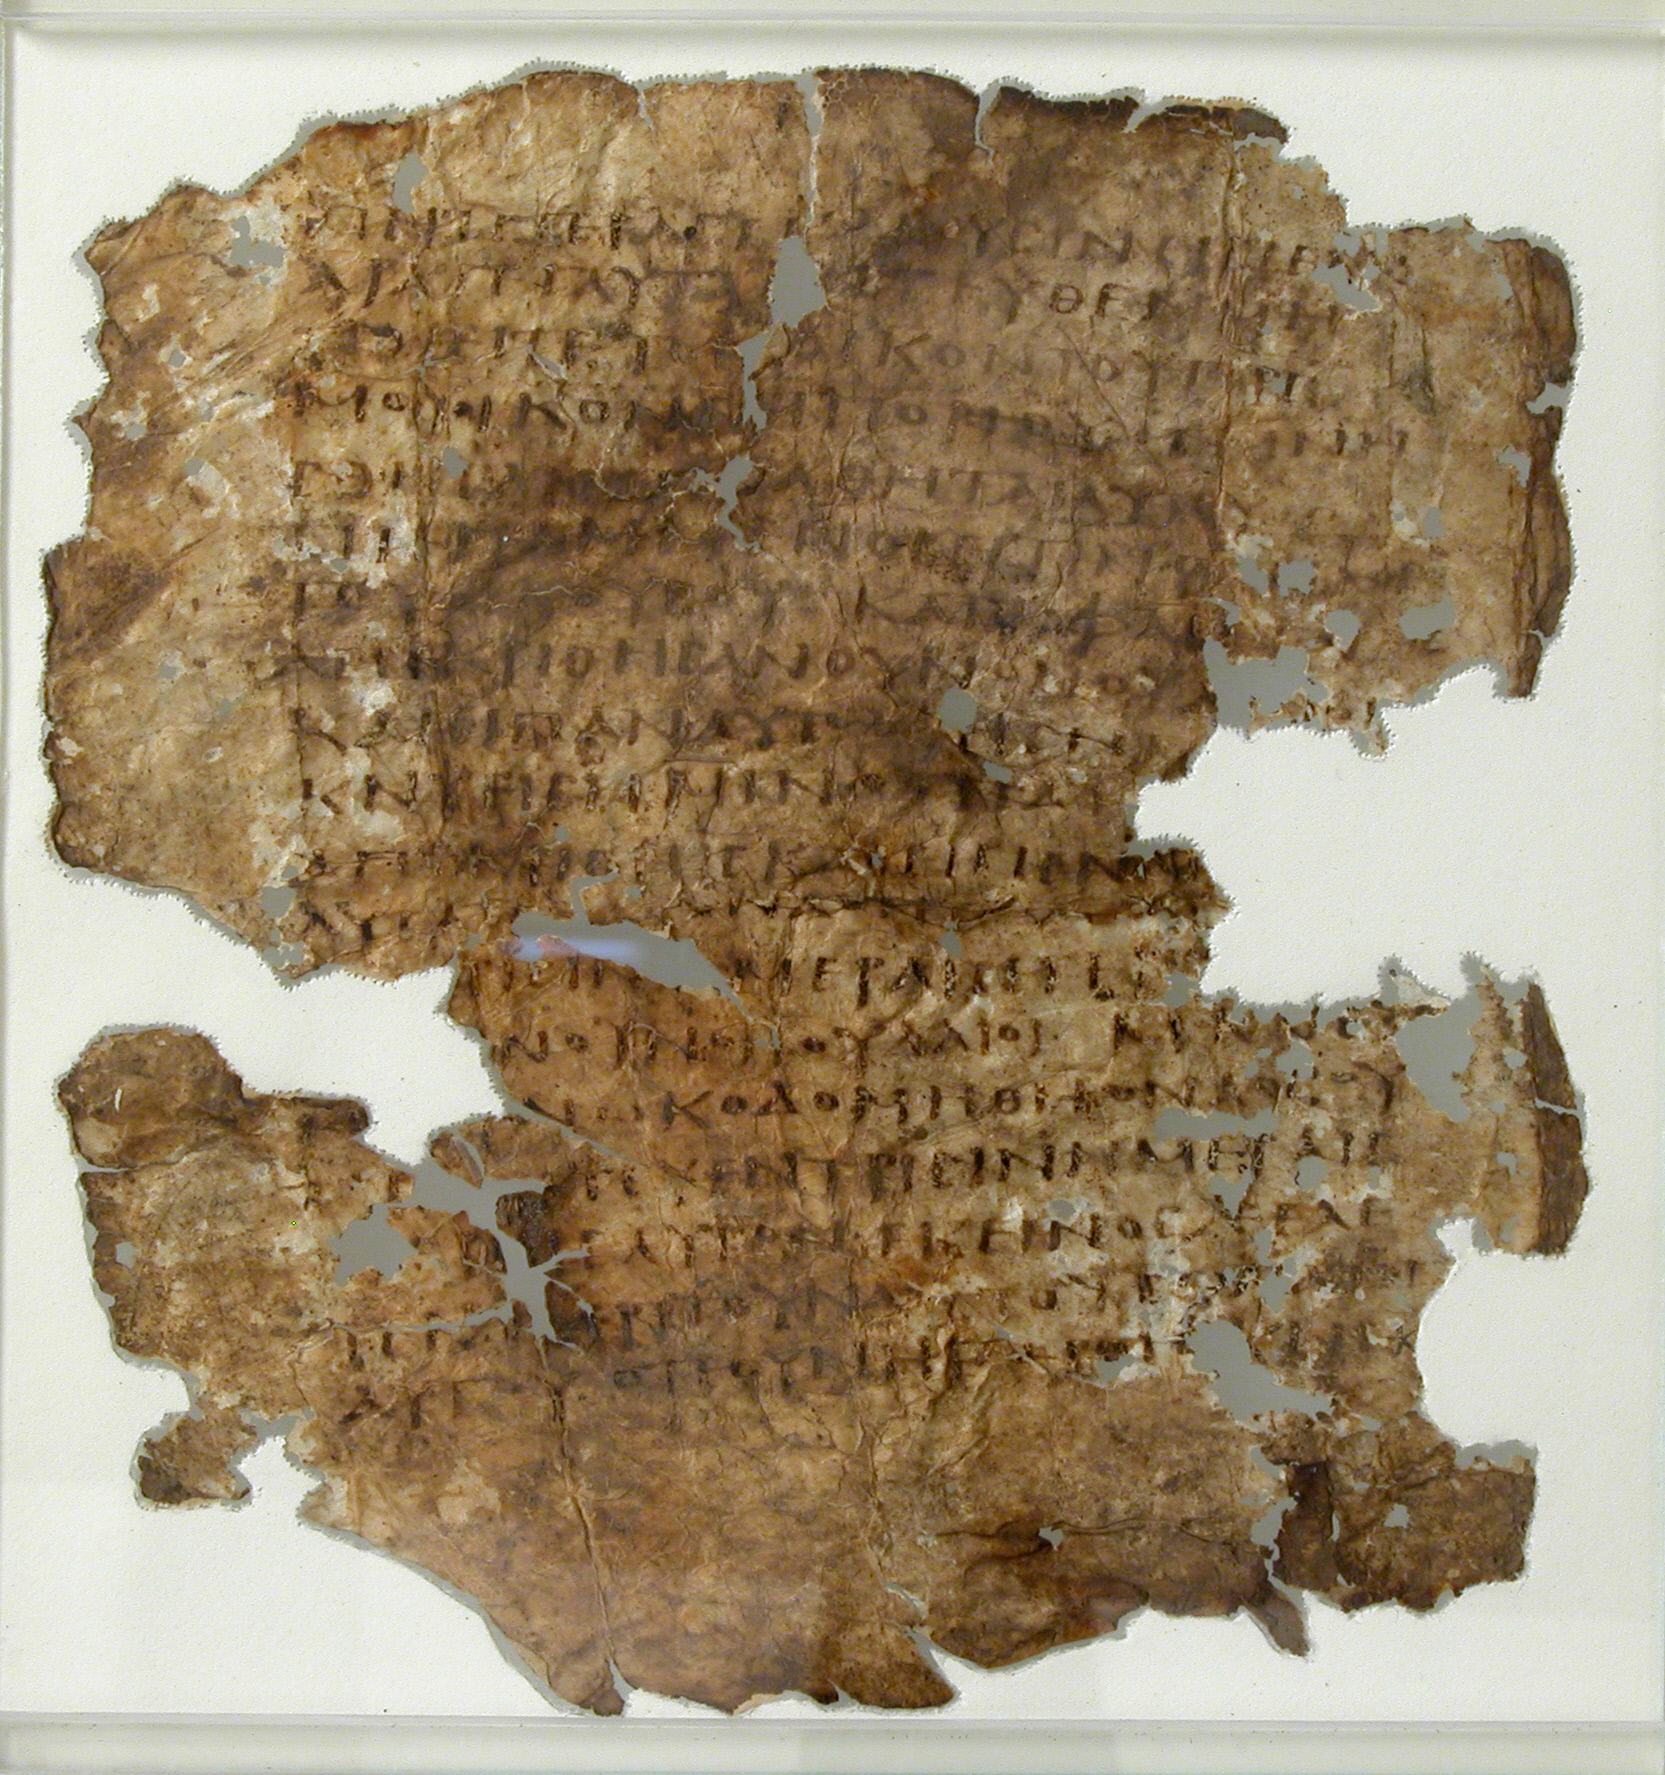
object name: manuscript leaf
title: Fragment of the Gospel of St. John 2:11-22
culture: egyptian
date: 301-400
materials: ink, parchment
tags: documents